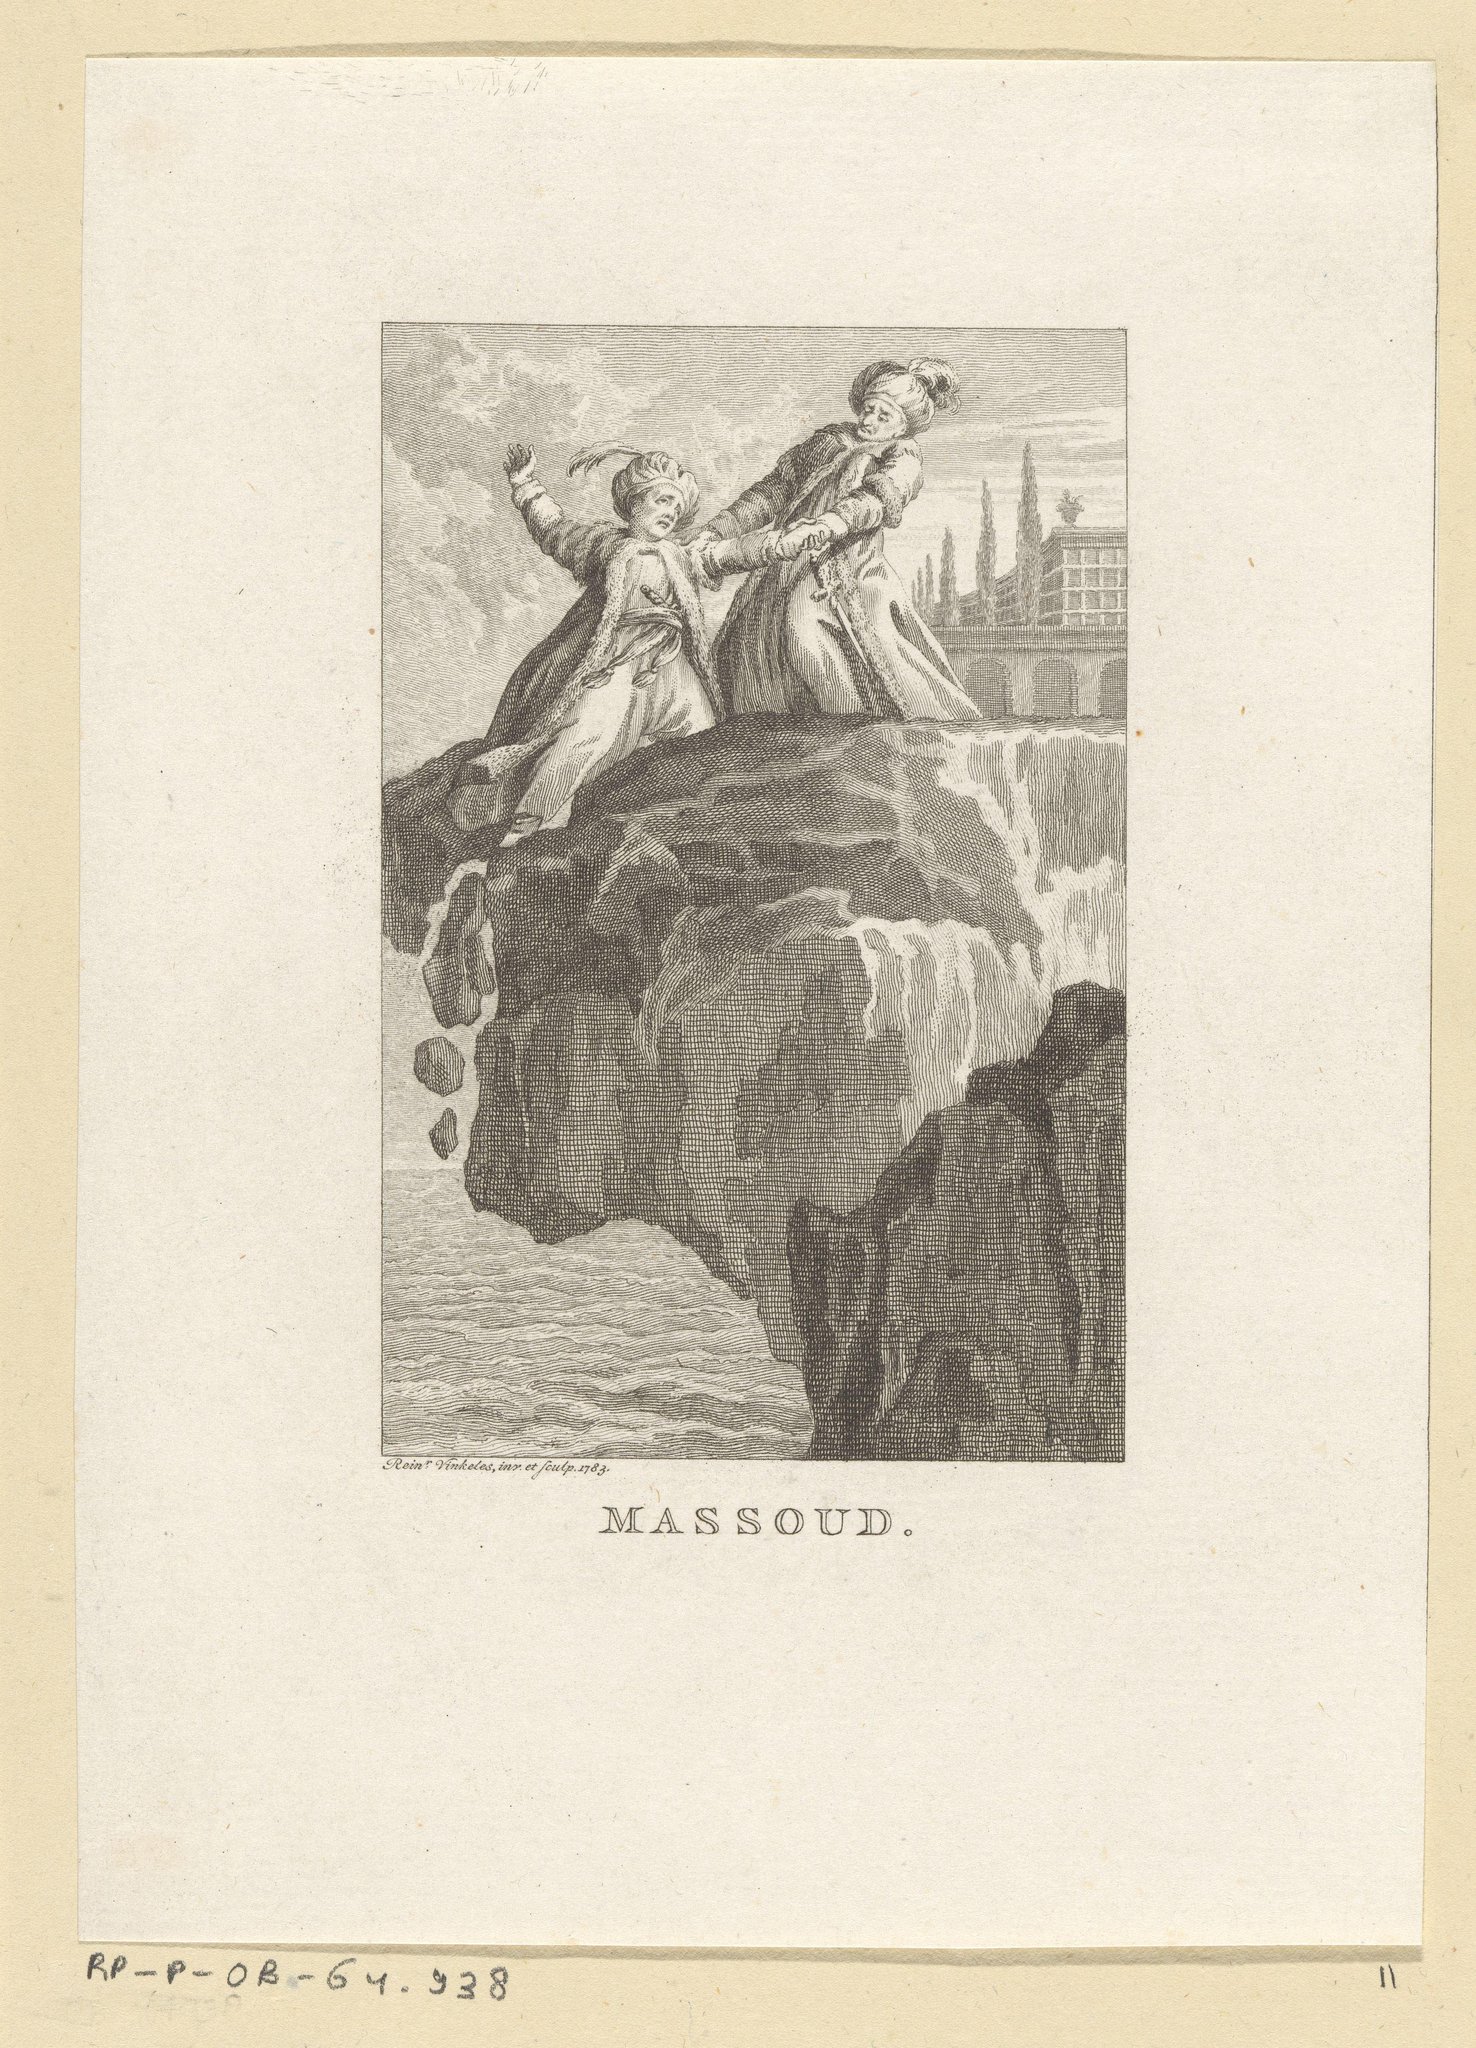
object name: print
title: Man redt een andere man die van een klif dreigt te storten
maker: reinier vinkeles (i)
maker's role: draughtsman, print maker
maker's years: 1741-1816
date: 1783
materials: paper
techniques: engraving, etching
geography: amsterdam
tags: life-saving service, head-gear: turban, coastal cliff or crag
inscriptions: collector's mark: Lugt 240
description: Deze prent is ook gebruikt als illustratie bij het verhaal 'Massoud' voor: Meissner, A.G. Zedelijke verhaalen, deel 8. Amsterdam: A. Mens Jansz., 1783.